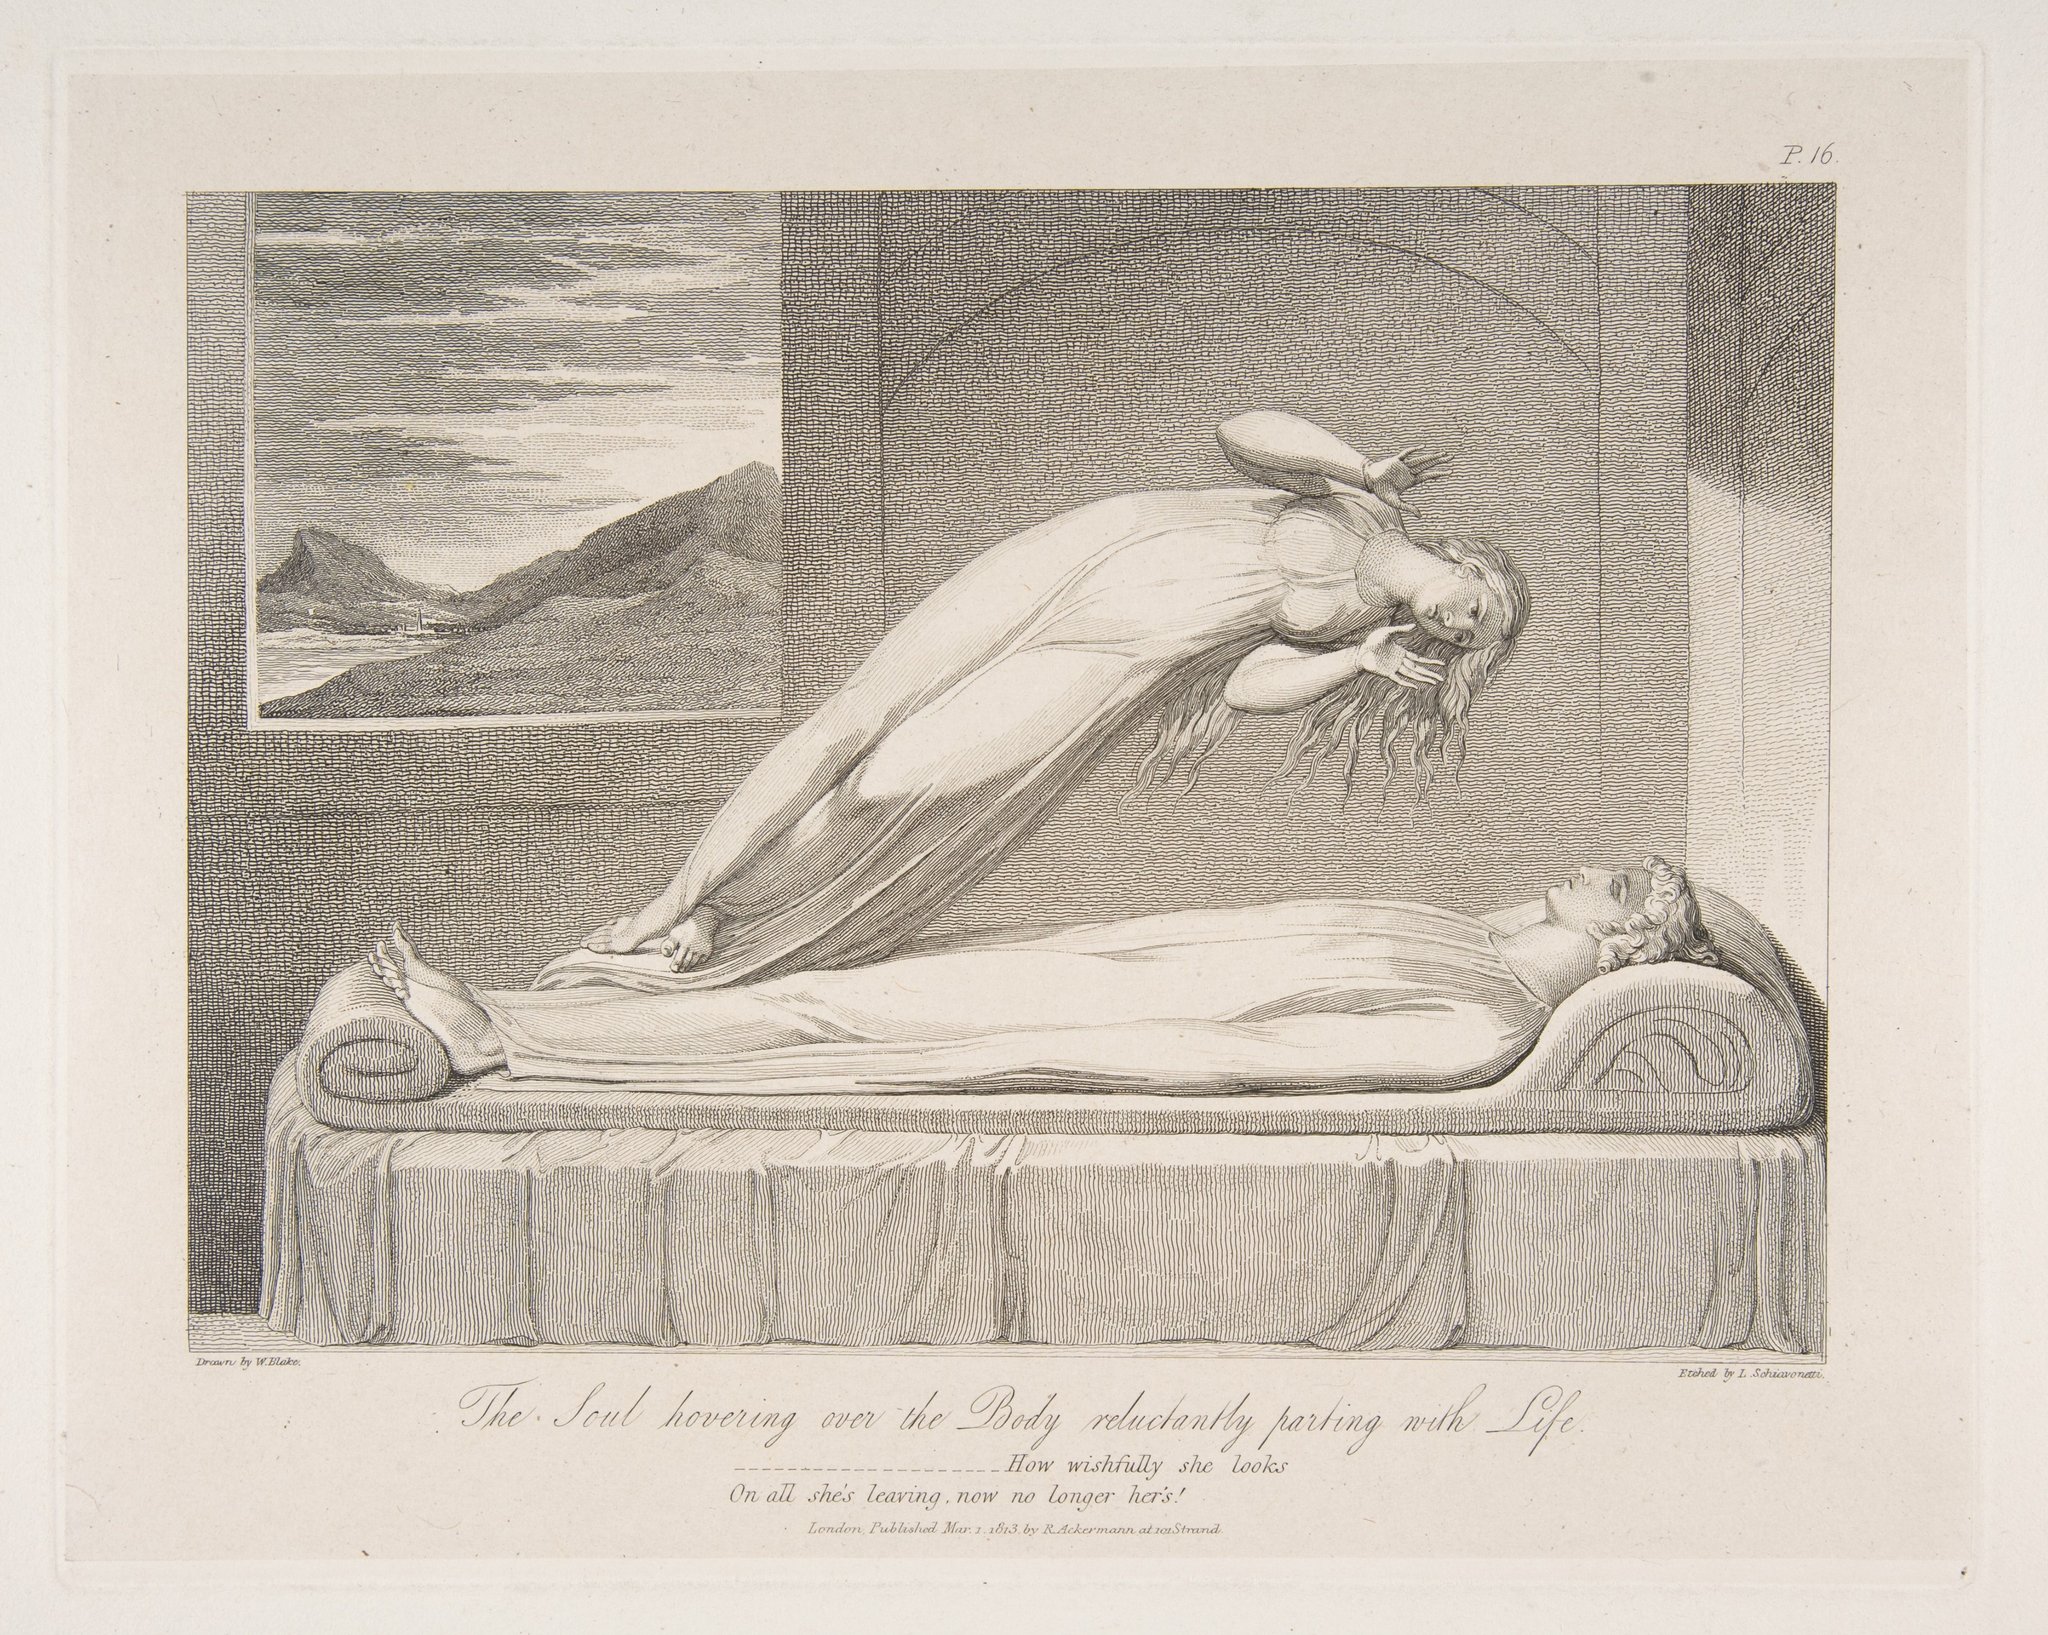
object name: print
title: The Soul Hovering over the Body, Reluctantly Parting with Life, from "The Grave," a Poem by Robert Blair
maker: william blake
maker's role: artist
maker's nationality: british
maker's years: 1757-1827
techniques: engraving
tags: women,death